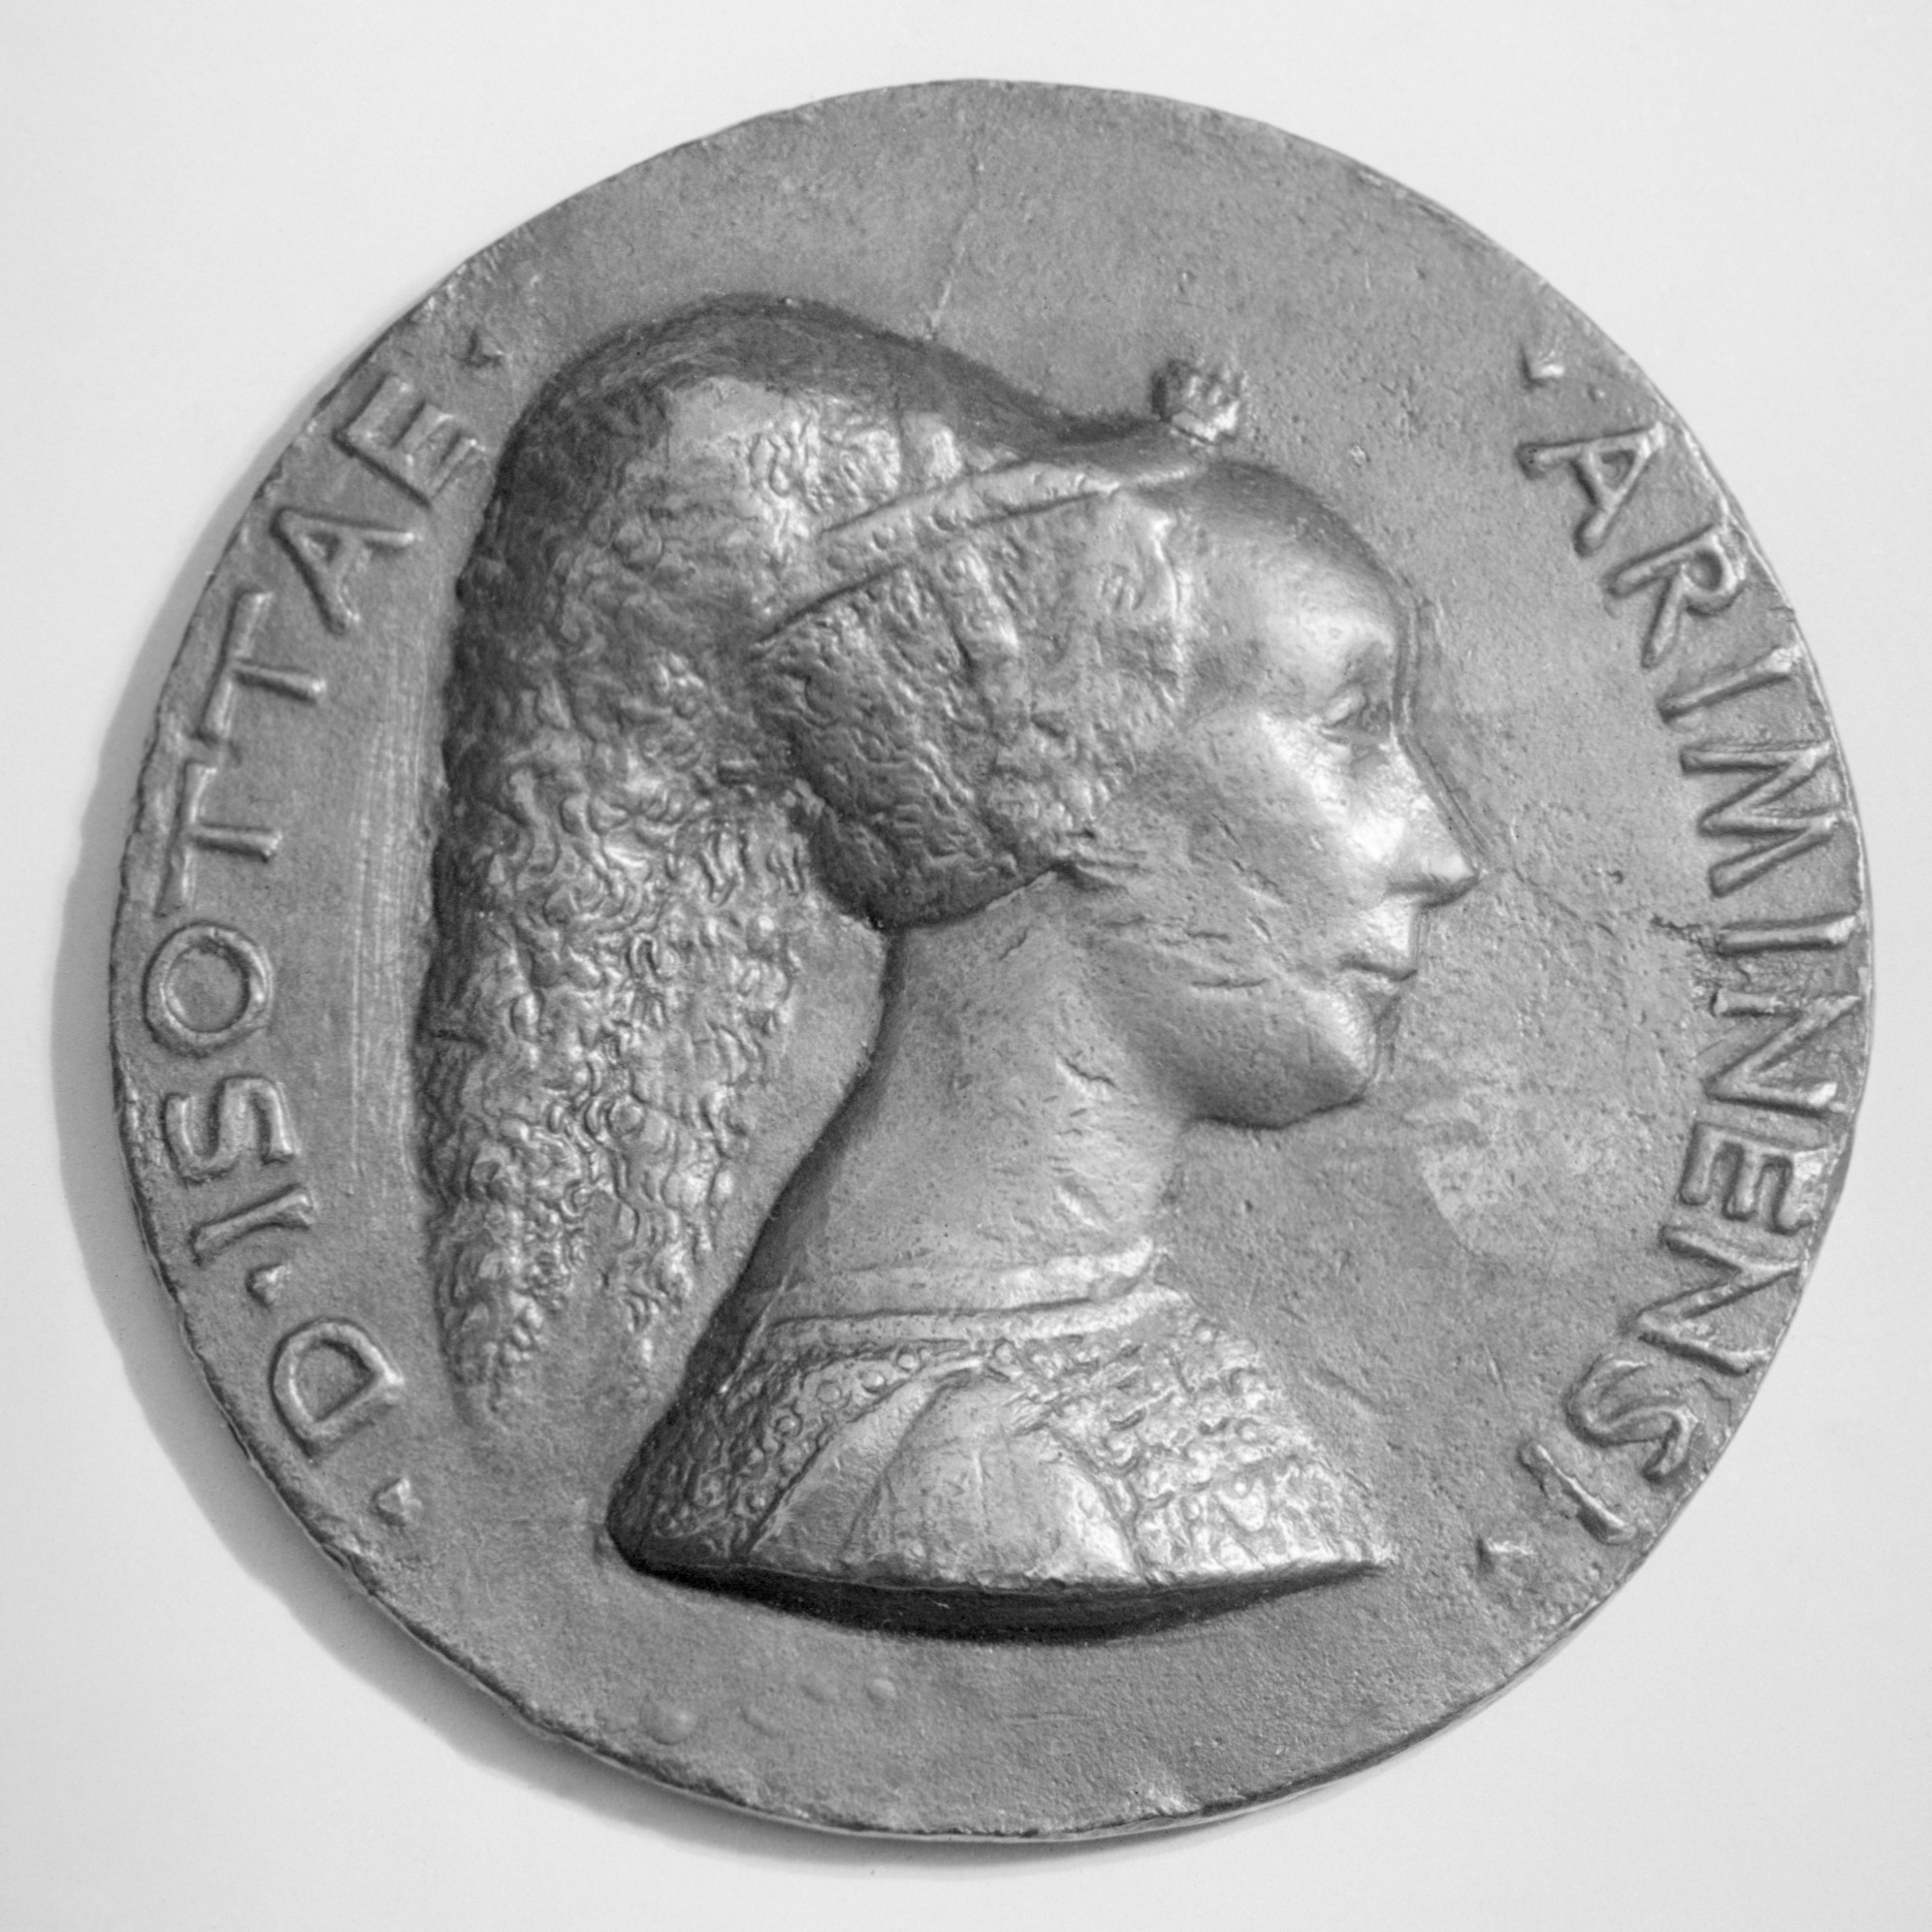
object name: medal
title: Isotta degli Atti of Rimini, d. 1470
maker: matteo de' pasti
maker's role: artist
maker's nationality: italian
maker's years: 1420-1467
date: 1446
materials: bronze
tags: profiles,women